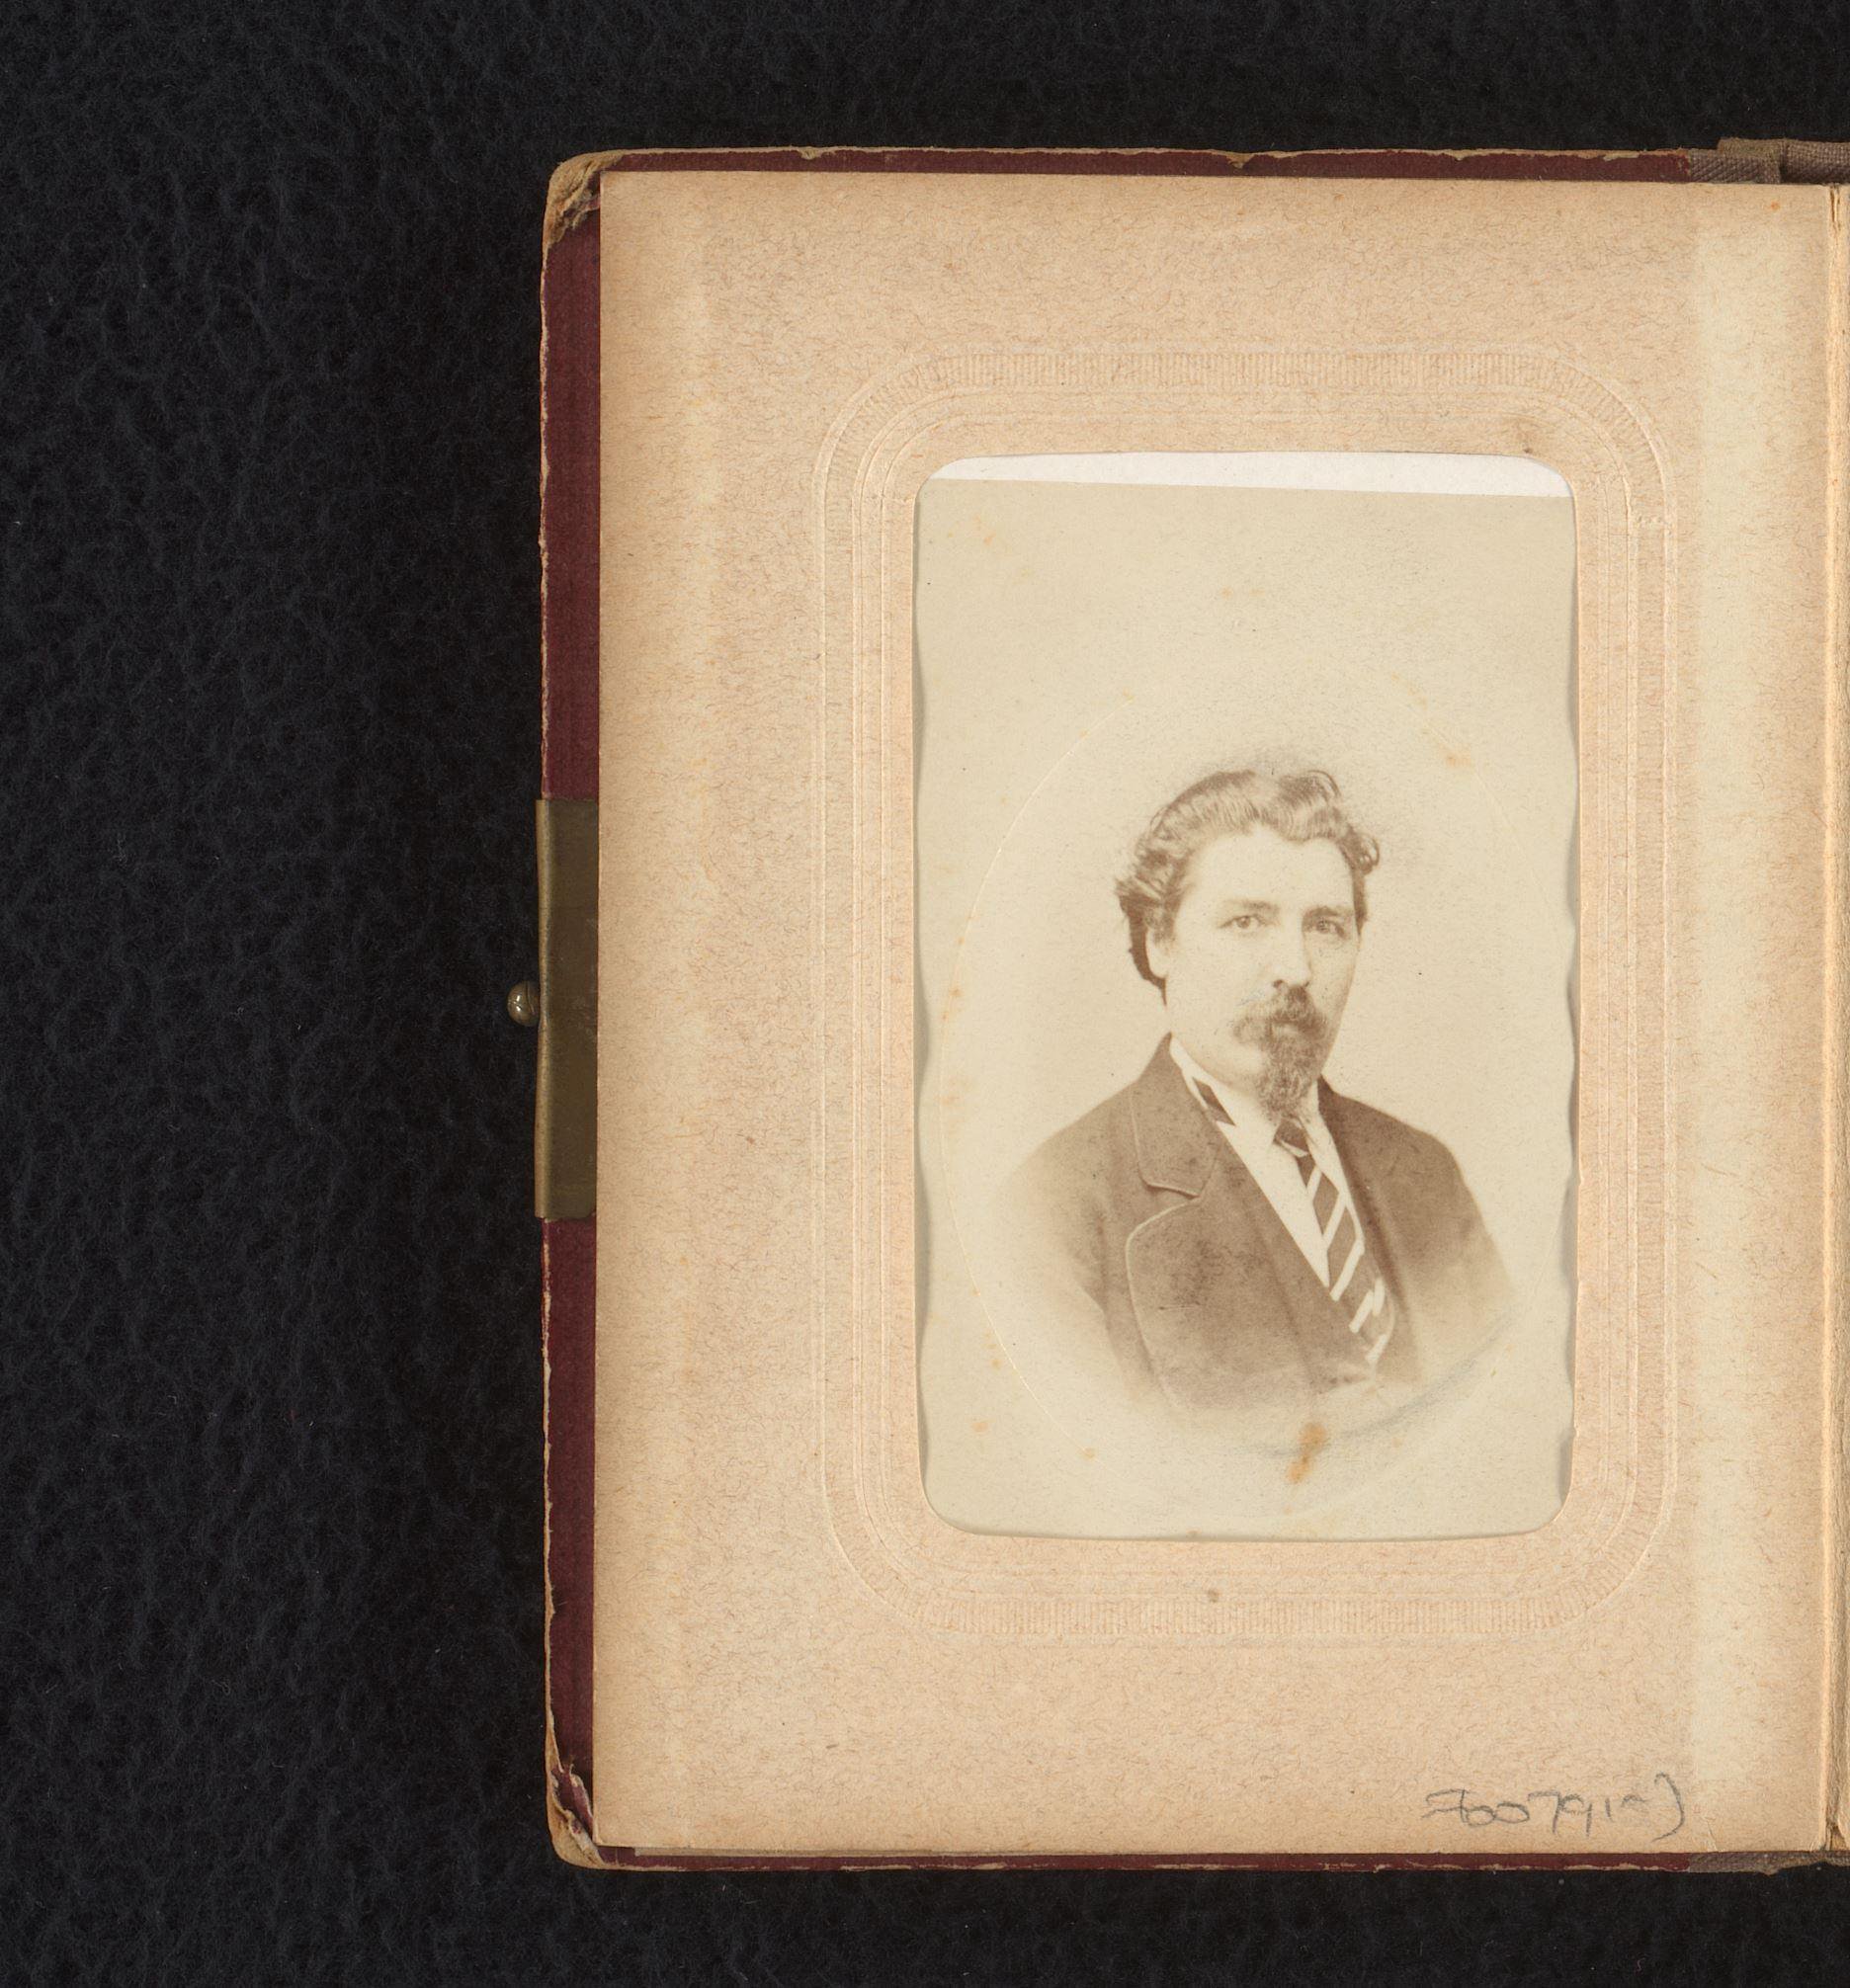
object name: carte de visite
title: Portret van een man met baard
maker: e. swift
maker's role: fotograaf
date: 1860-1890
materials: cardboard, photographic support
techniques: photograph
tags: adult man, historical persons, beard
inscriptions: inscription: ‘E.Swift & Son/ Artist & Photographers/ 126, Bond Street/ Liverpool’